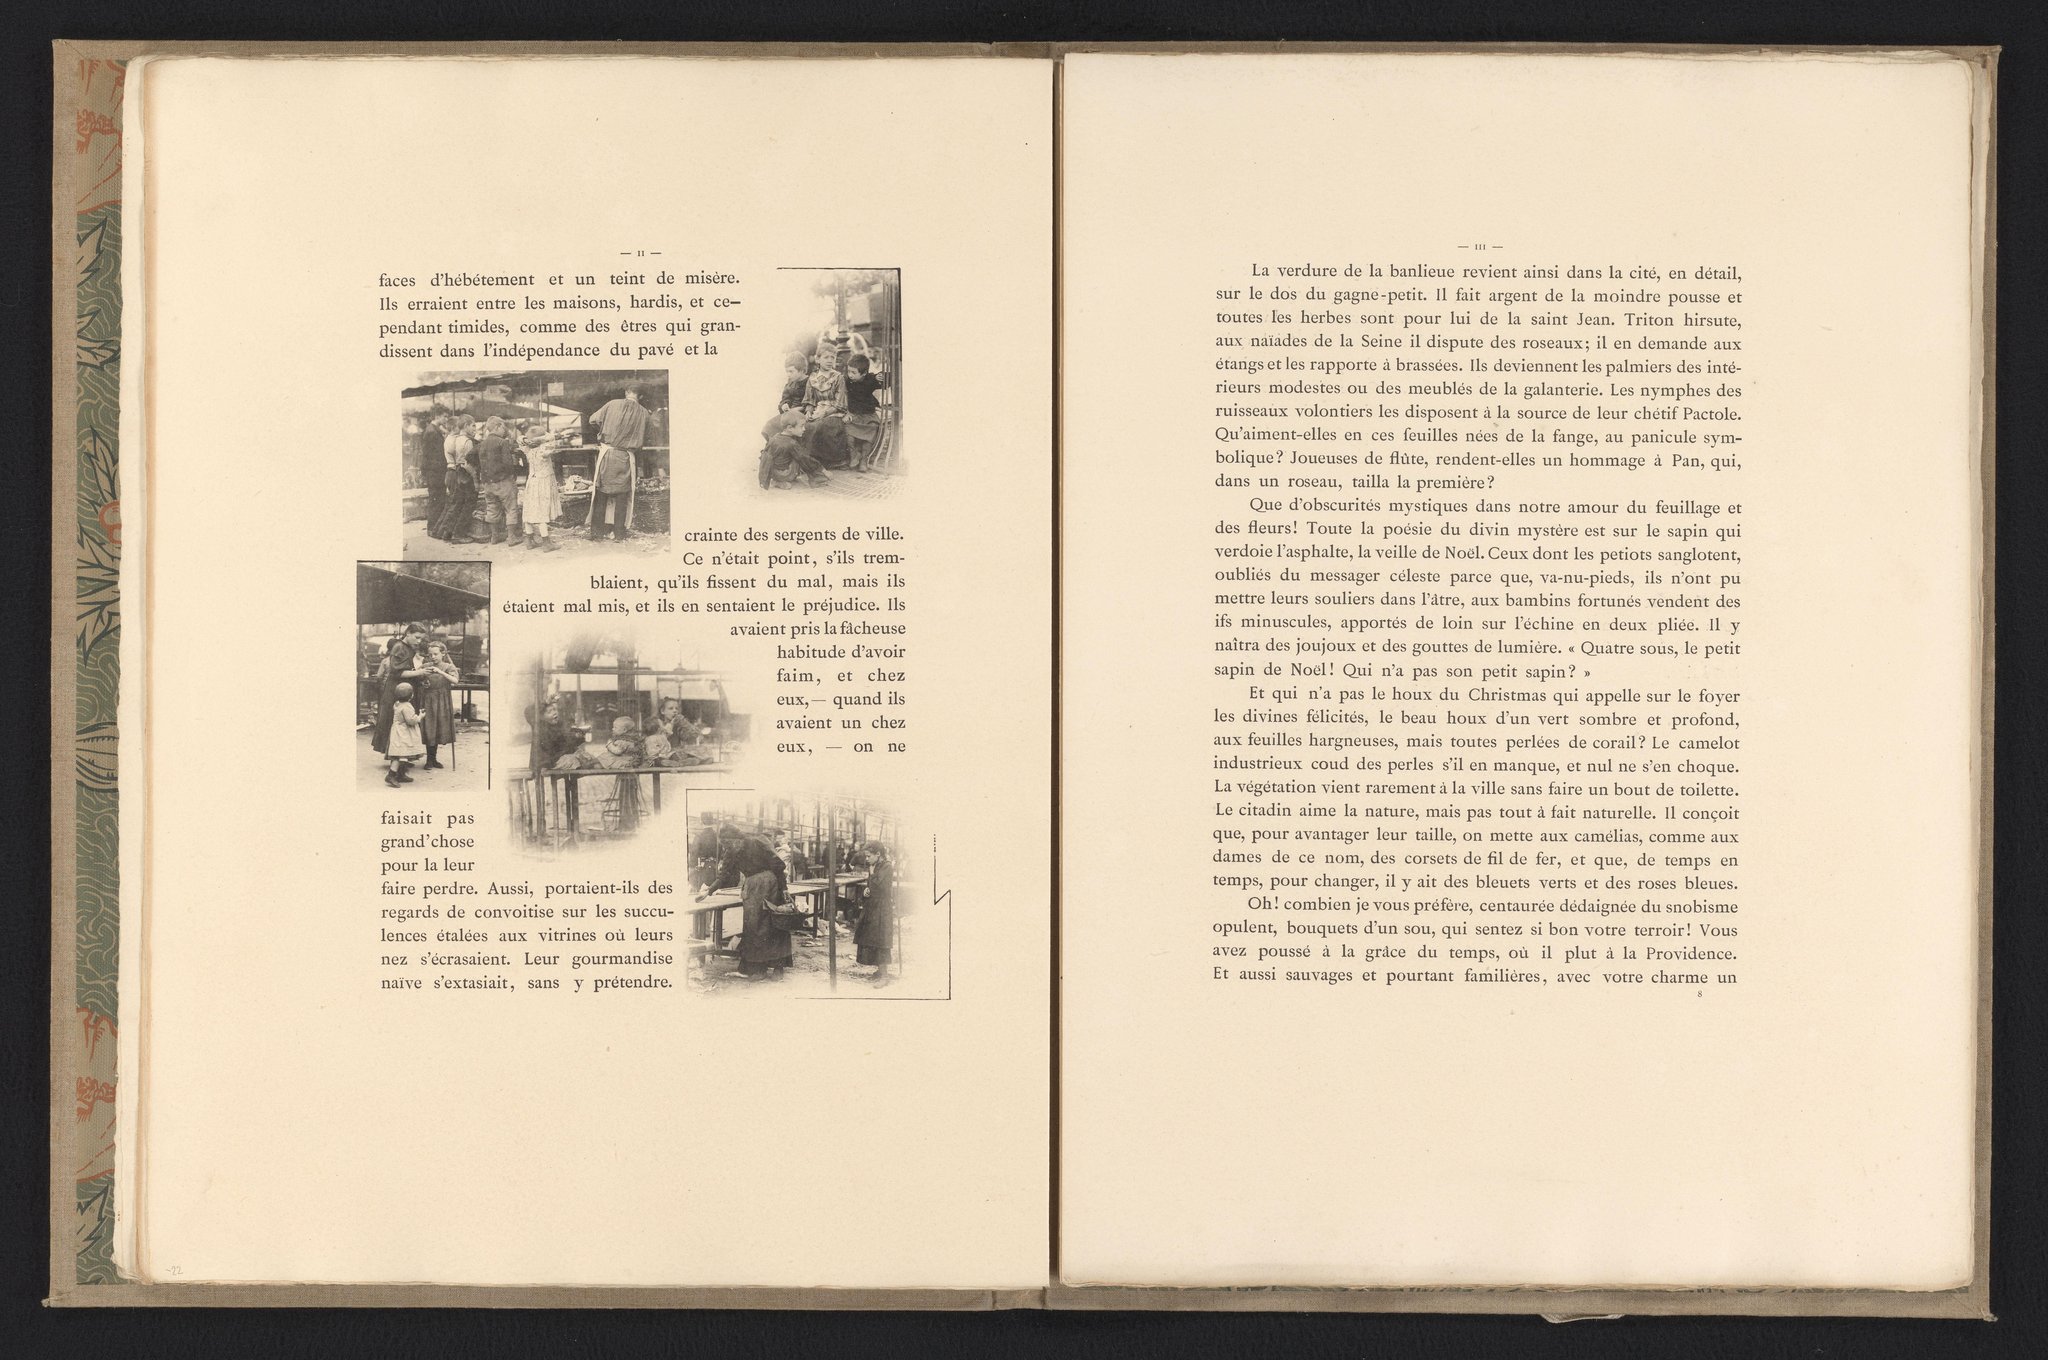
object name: photomechanical print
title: Á travers les rues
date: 1896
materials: paper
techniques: photograph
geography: châteaudun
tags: child, market, paris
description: Prenten op achtendertigste ongenummerde pagina.